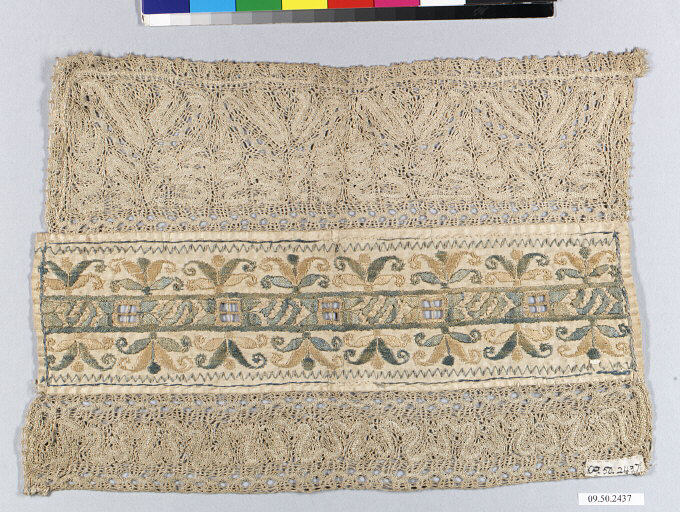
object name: cuff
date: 1801-1900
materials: linen, silk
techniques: lace